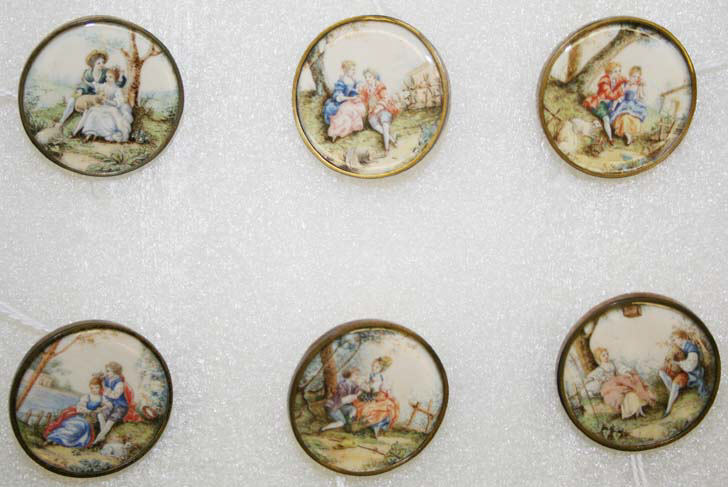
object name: button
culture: french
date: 1780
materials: glass, ivory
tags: couples,men,women